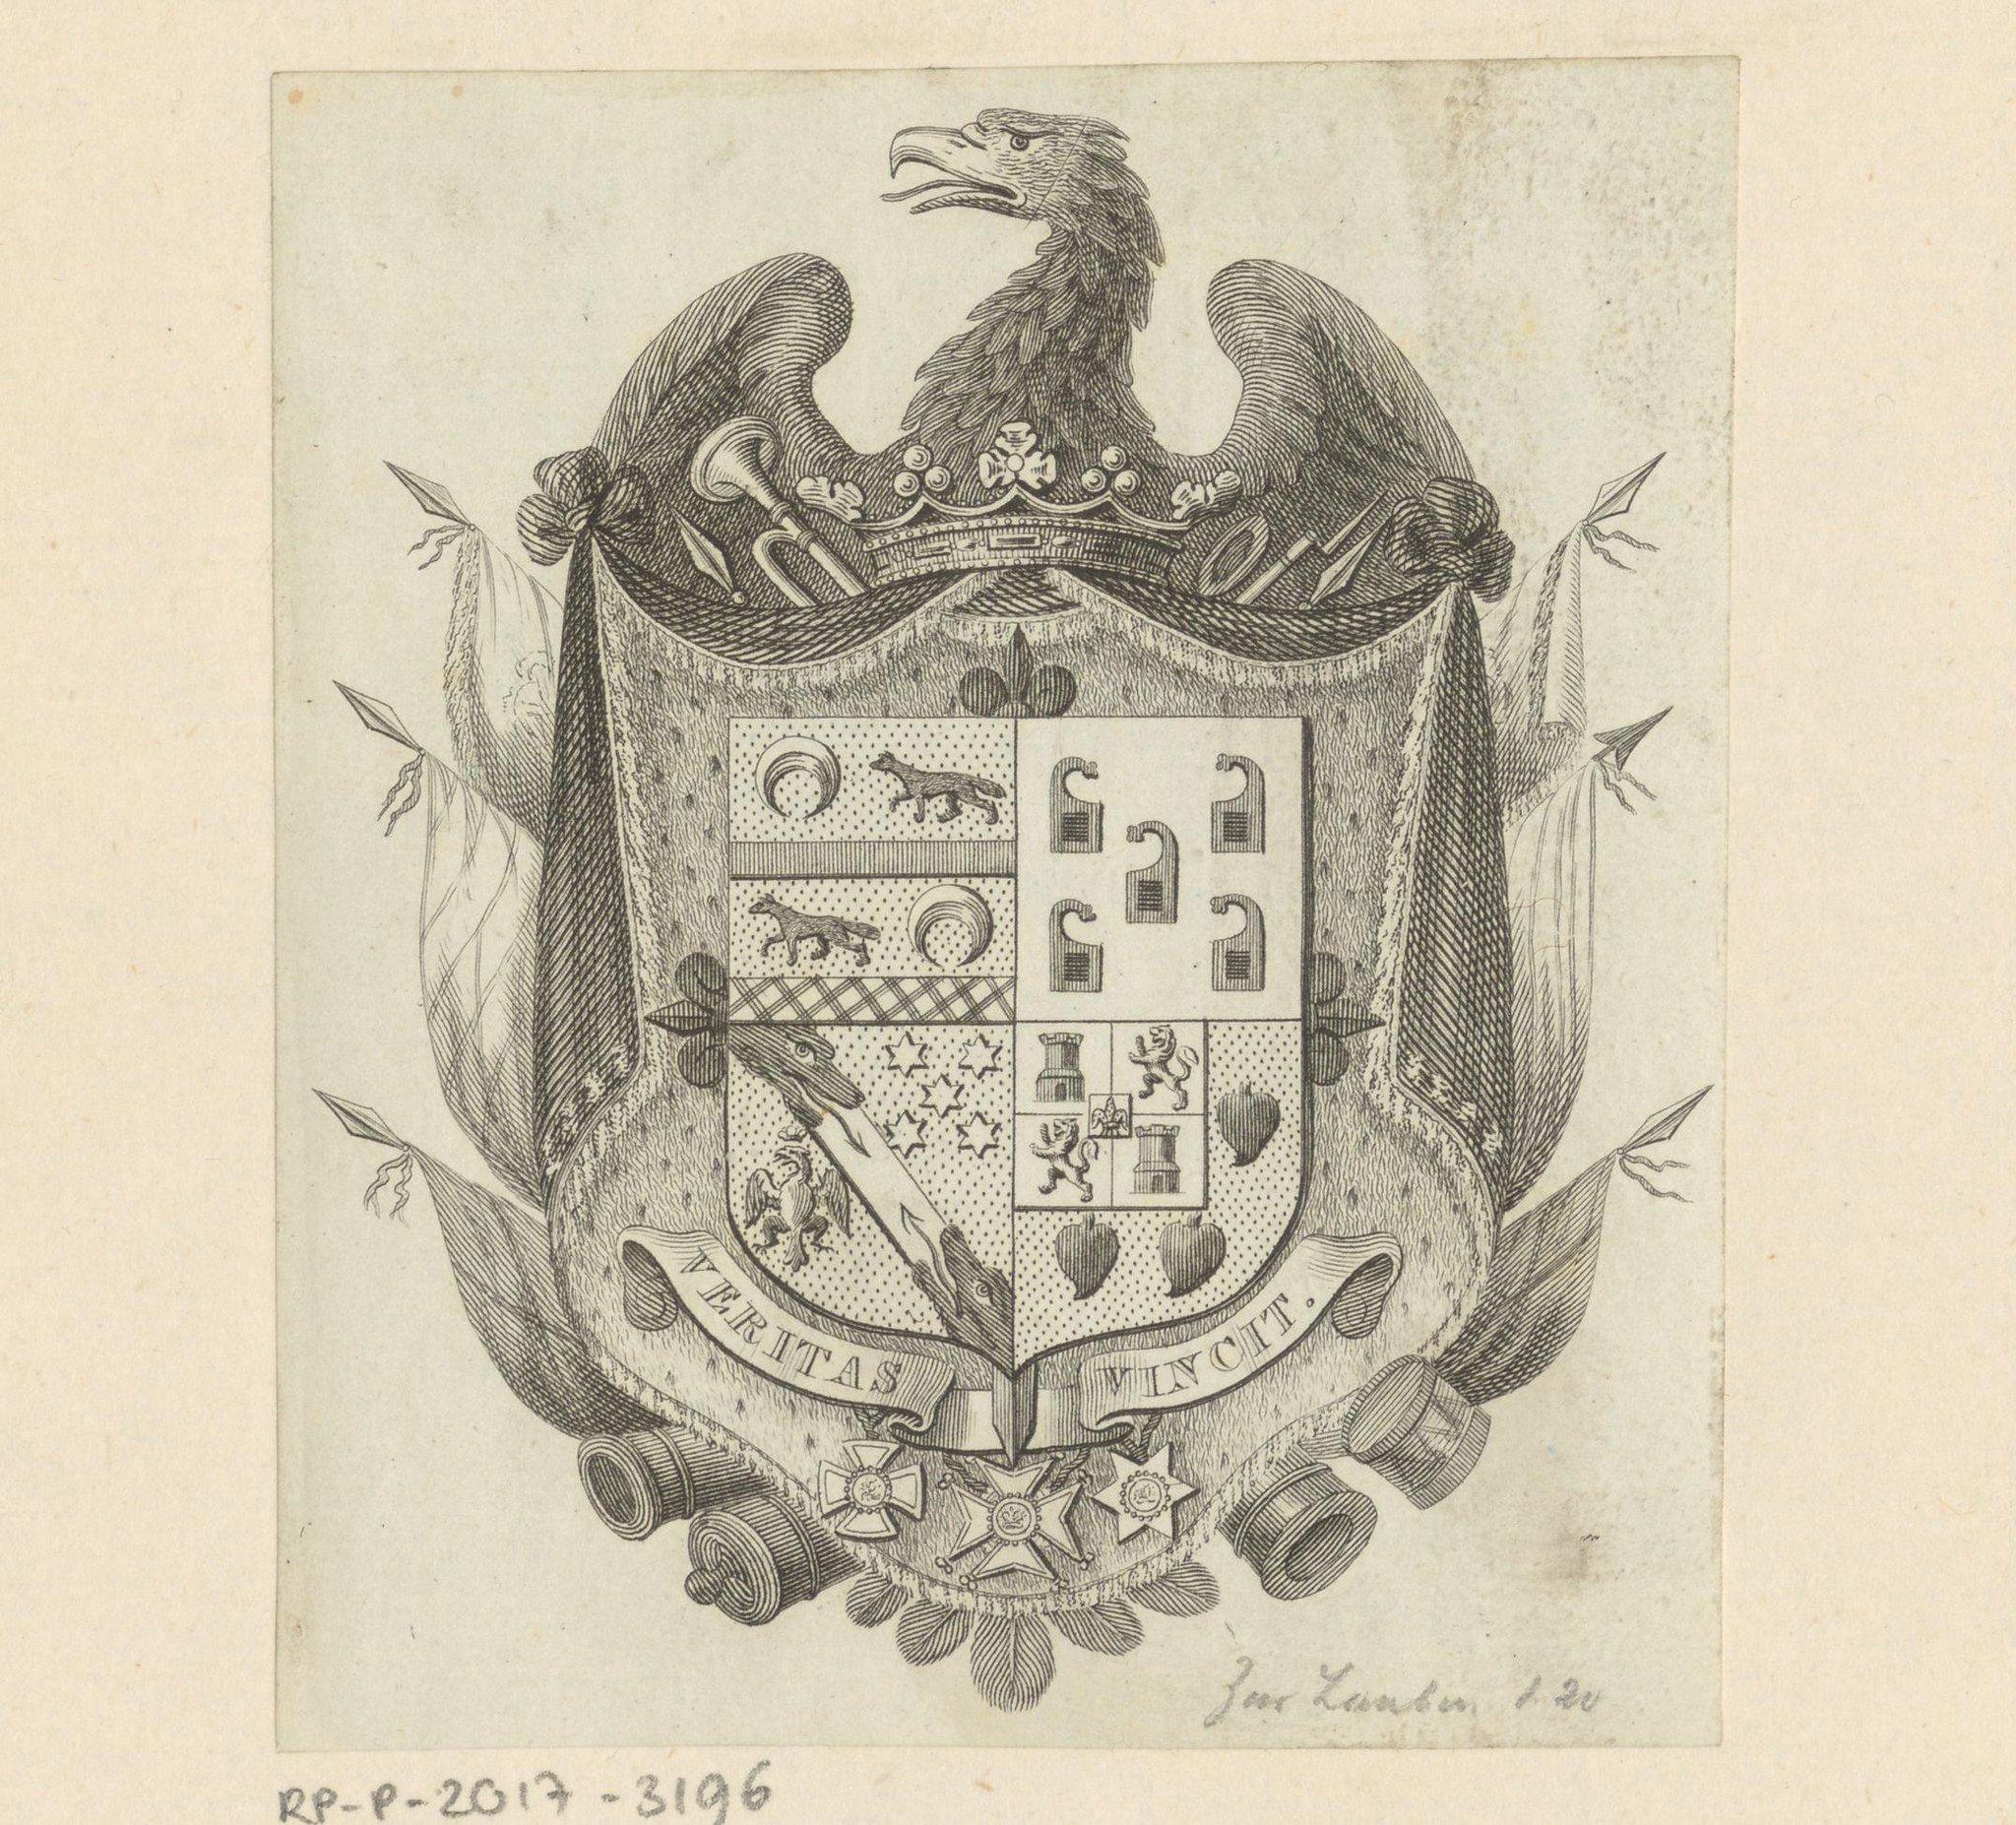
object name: bookplate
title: Veritas vincit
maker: Anonymous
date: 1750-1850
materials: paper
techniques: engraving, etching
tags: predatory birds: eagle, firearms: cannon, armorial bearing, heraldry, flag, colours (as symbol of the state, etc.)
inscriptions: inscription: ‘zur Zauben f. 20 (?)’